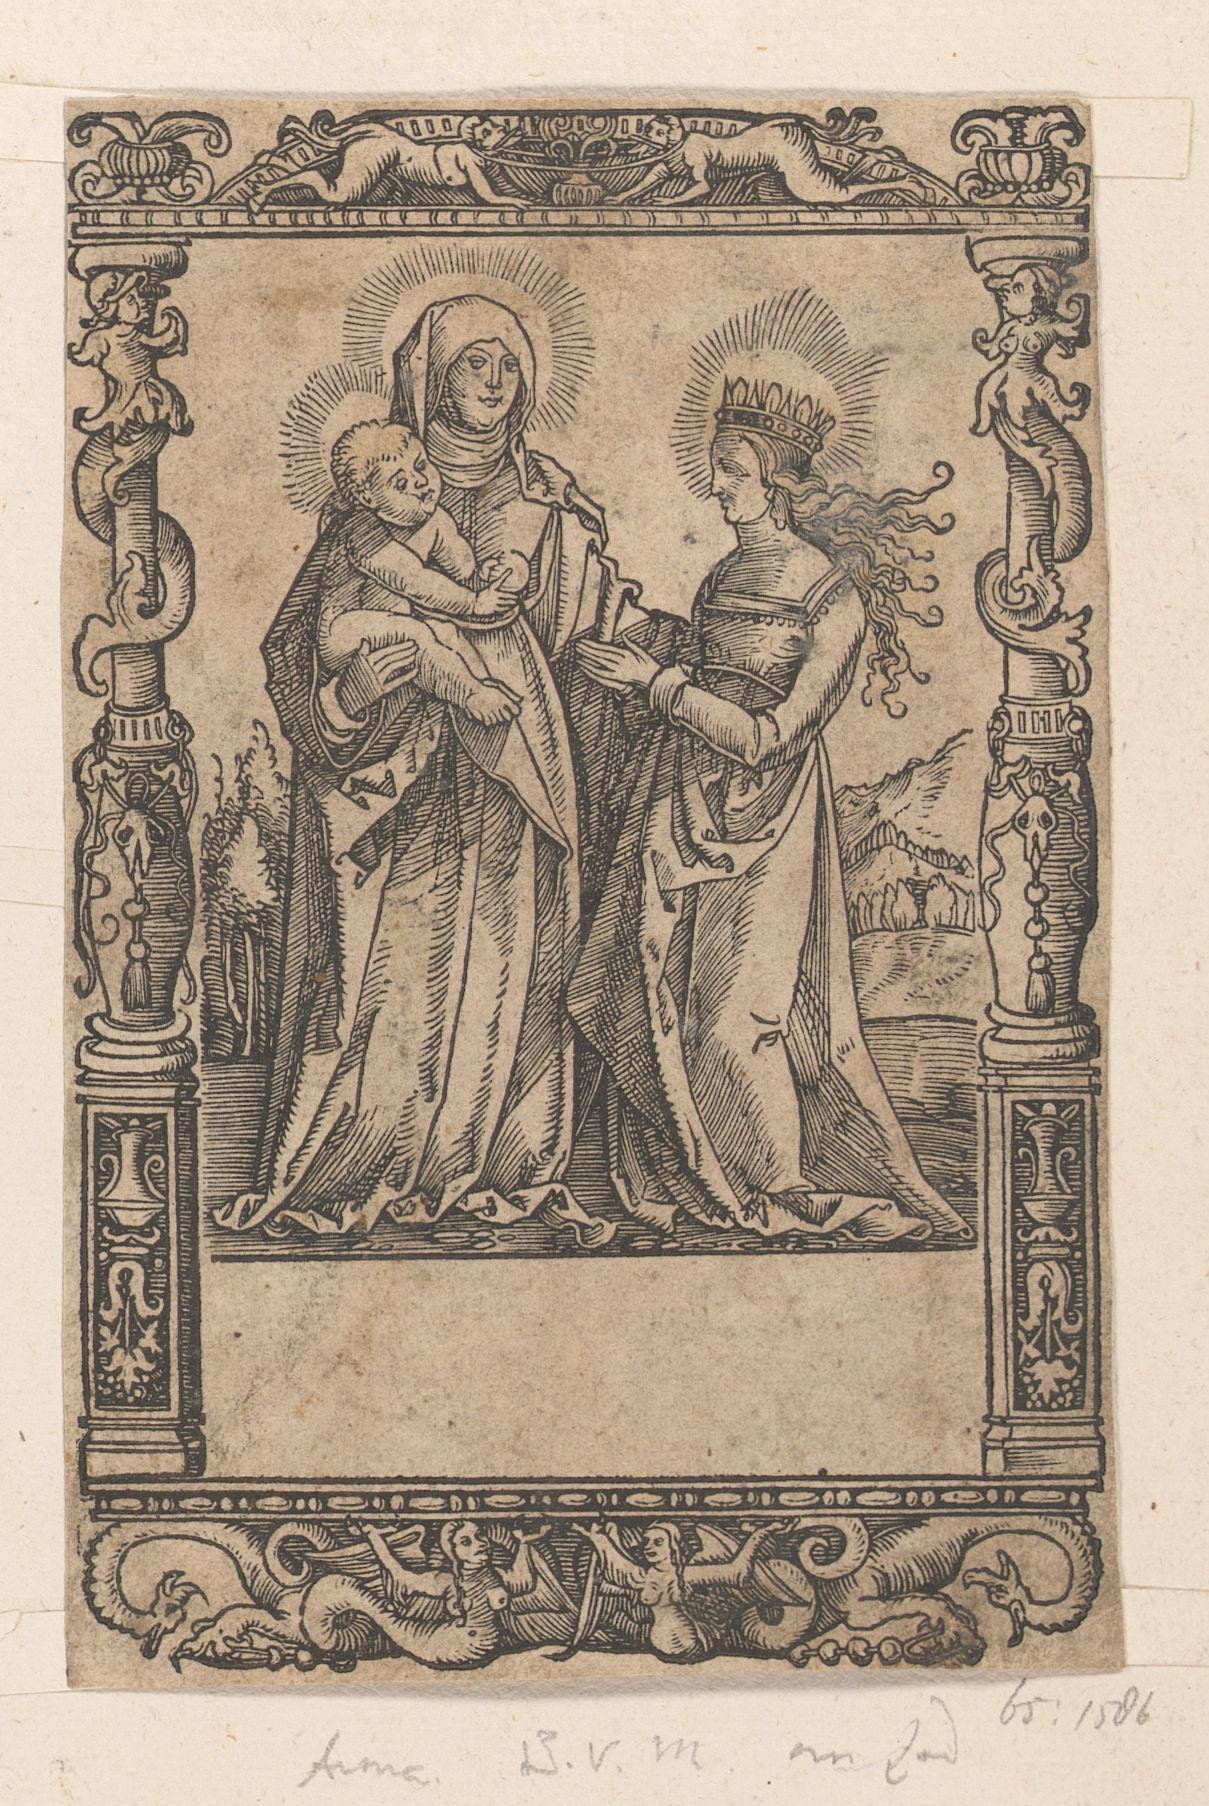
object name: album leaf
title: Anna te drieën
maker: hans springinklee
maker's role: print maker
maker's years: -1540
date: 1516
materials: paper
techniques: woodcut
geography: nuremberg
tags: 'anna selbdritt', i.e. anna, mary and christ-child close together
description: Anna houdt het Christuskind op haar arm. Haar andere arm slaat ze om Maria heen, die een kroon draagt. Rond de voorstelling een ornamentele omlijsting. Prent maakt deel uit van een album.